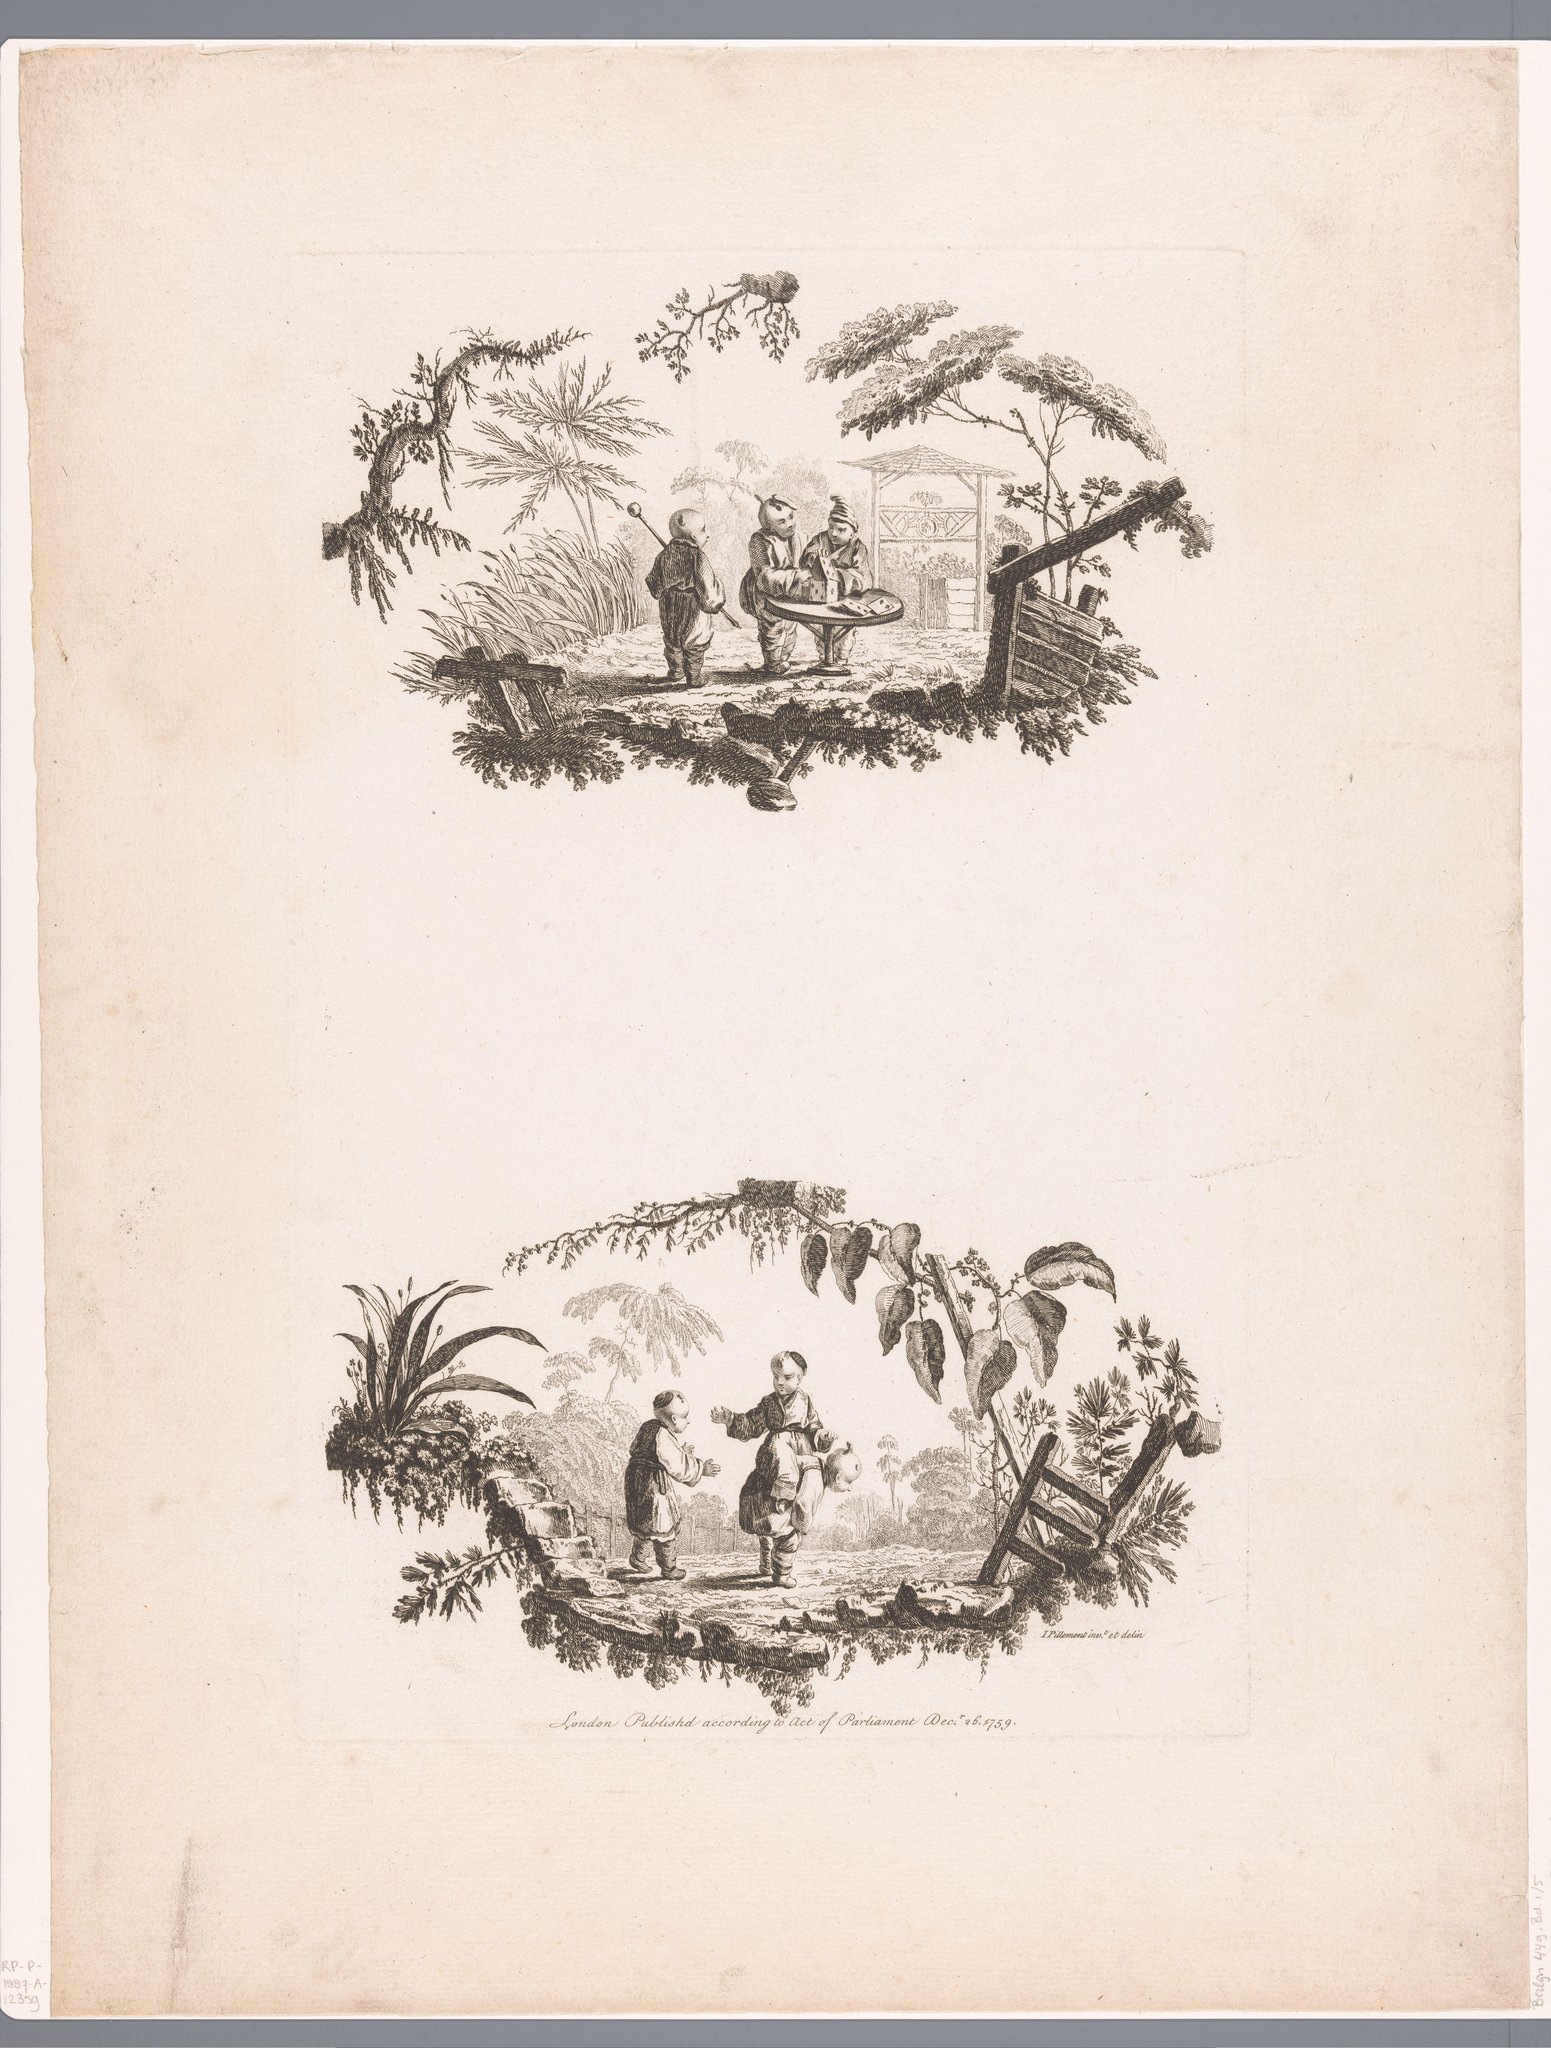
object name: ornament print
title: Recueil de Plusieurs Jeux d'Enfants Chinois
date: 1759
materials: paper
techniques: etching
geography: london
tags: children's games and plays, pick-a-back, piggyback, card games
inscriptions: collector's mark: Lugt 2228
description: Boven: Twee Chinese kinderen staan bij een ronde tafel en bouwen een kaartenhuis. Een derde kind met een stok komt aangelopen. Onder: Een Chinees kind zit op de rug van een ander kind. Links staat een derde kind. Rondom beide voorstellingen een omlijsting met hekken en bladeren.